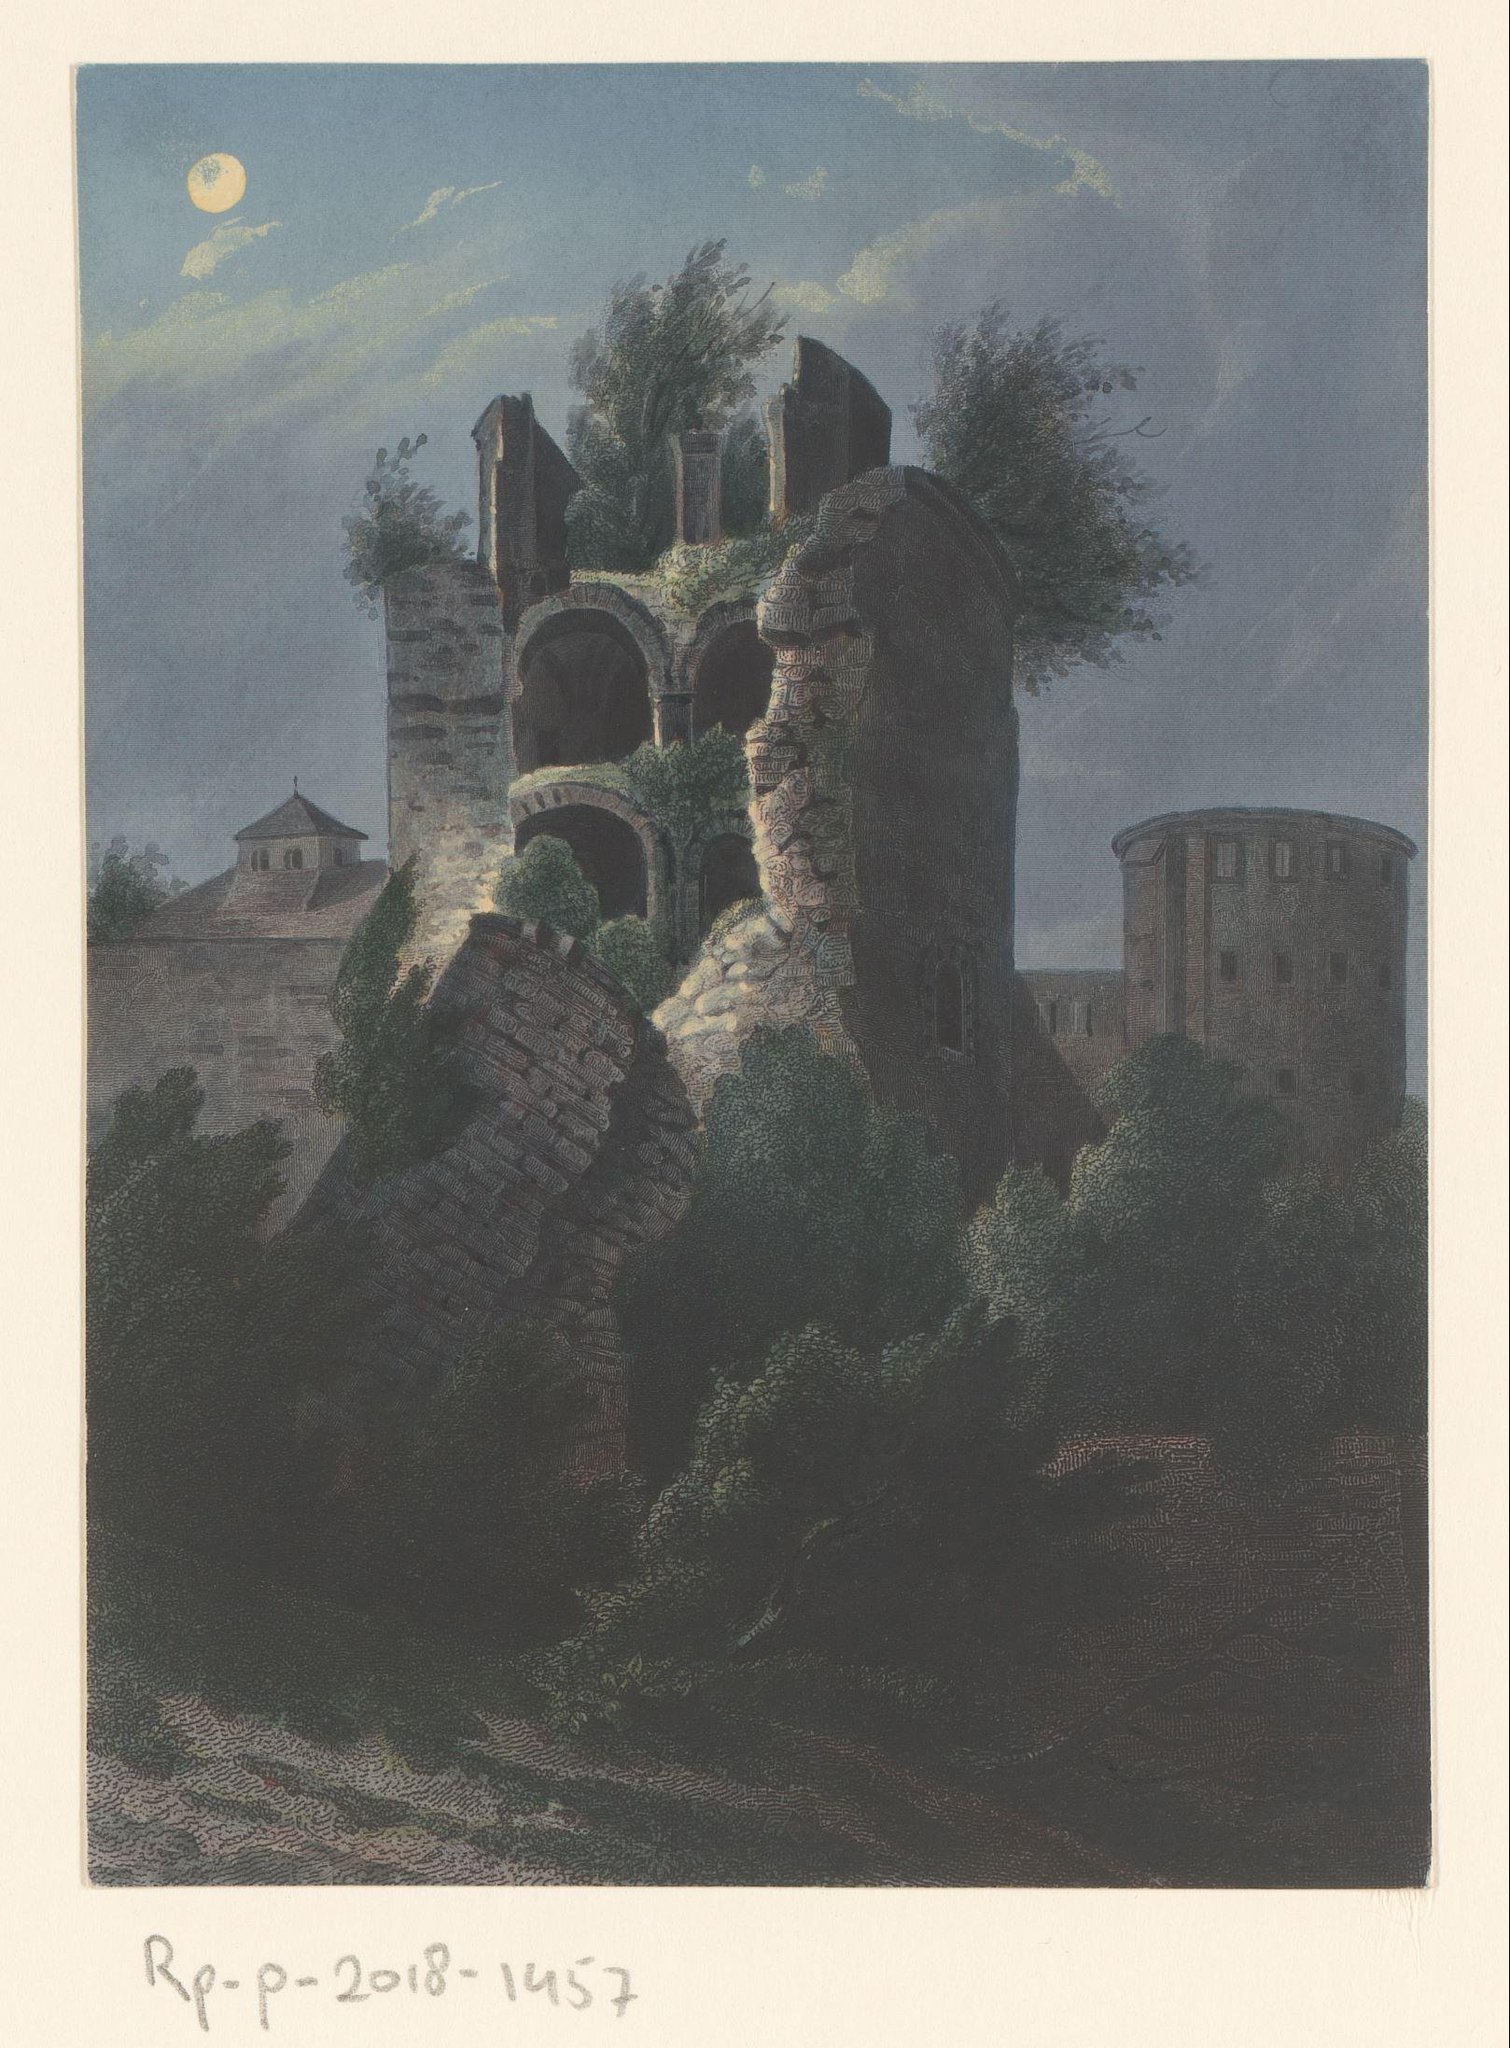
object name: print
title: Gezicht op de ruïne van een toren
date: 1850-1899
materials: paper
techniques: etching, hand coloring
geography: heidelberg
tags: ruin of a dwelling, house, castle, etc.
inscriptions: collector's mark: Lugt 2228